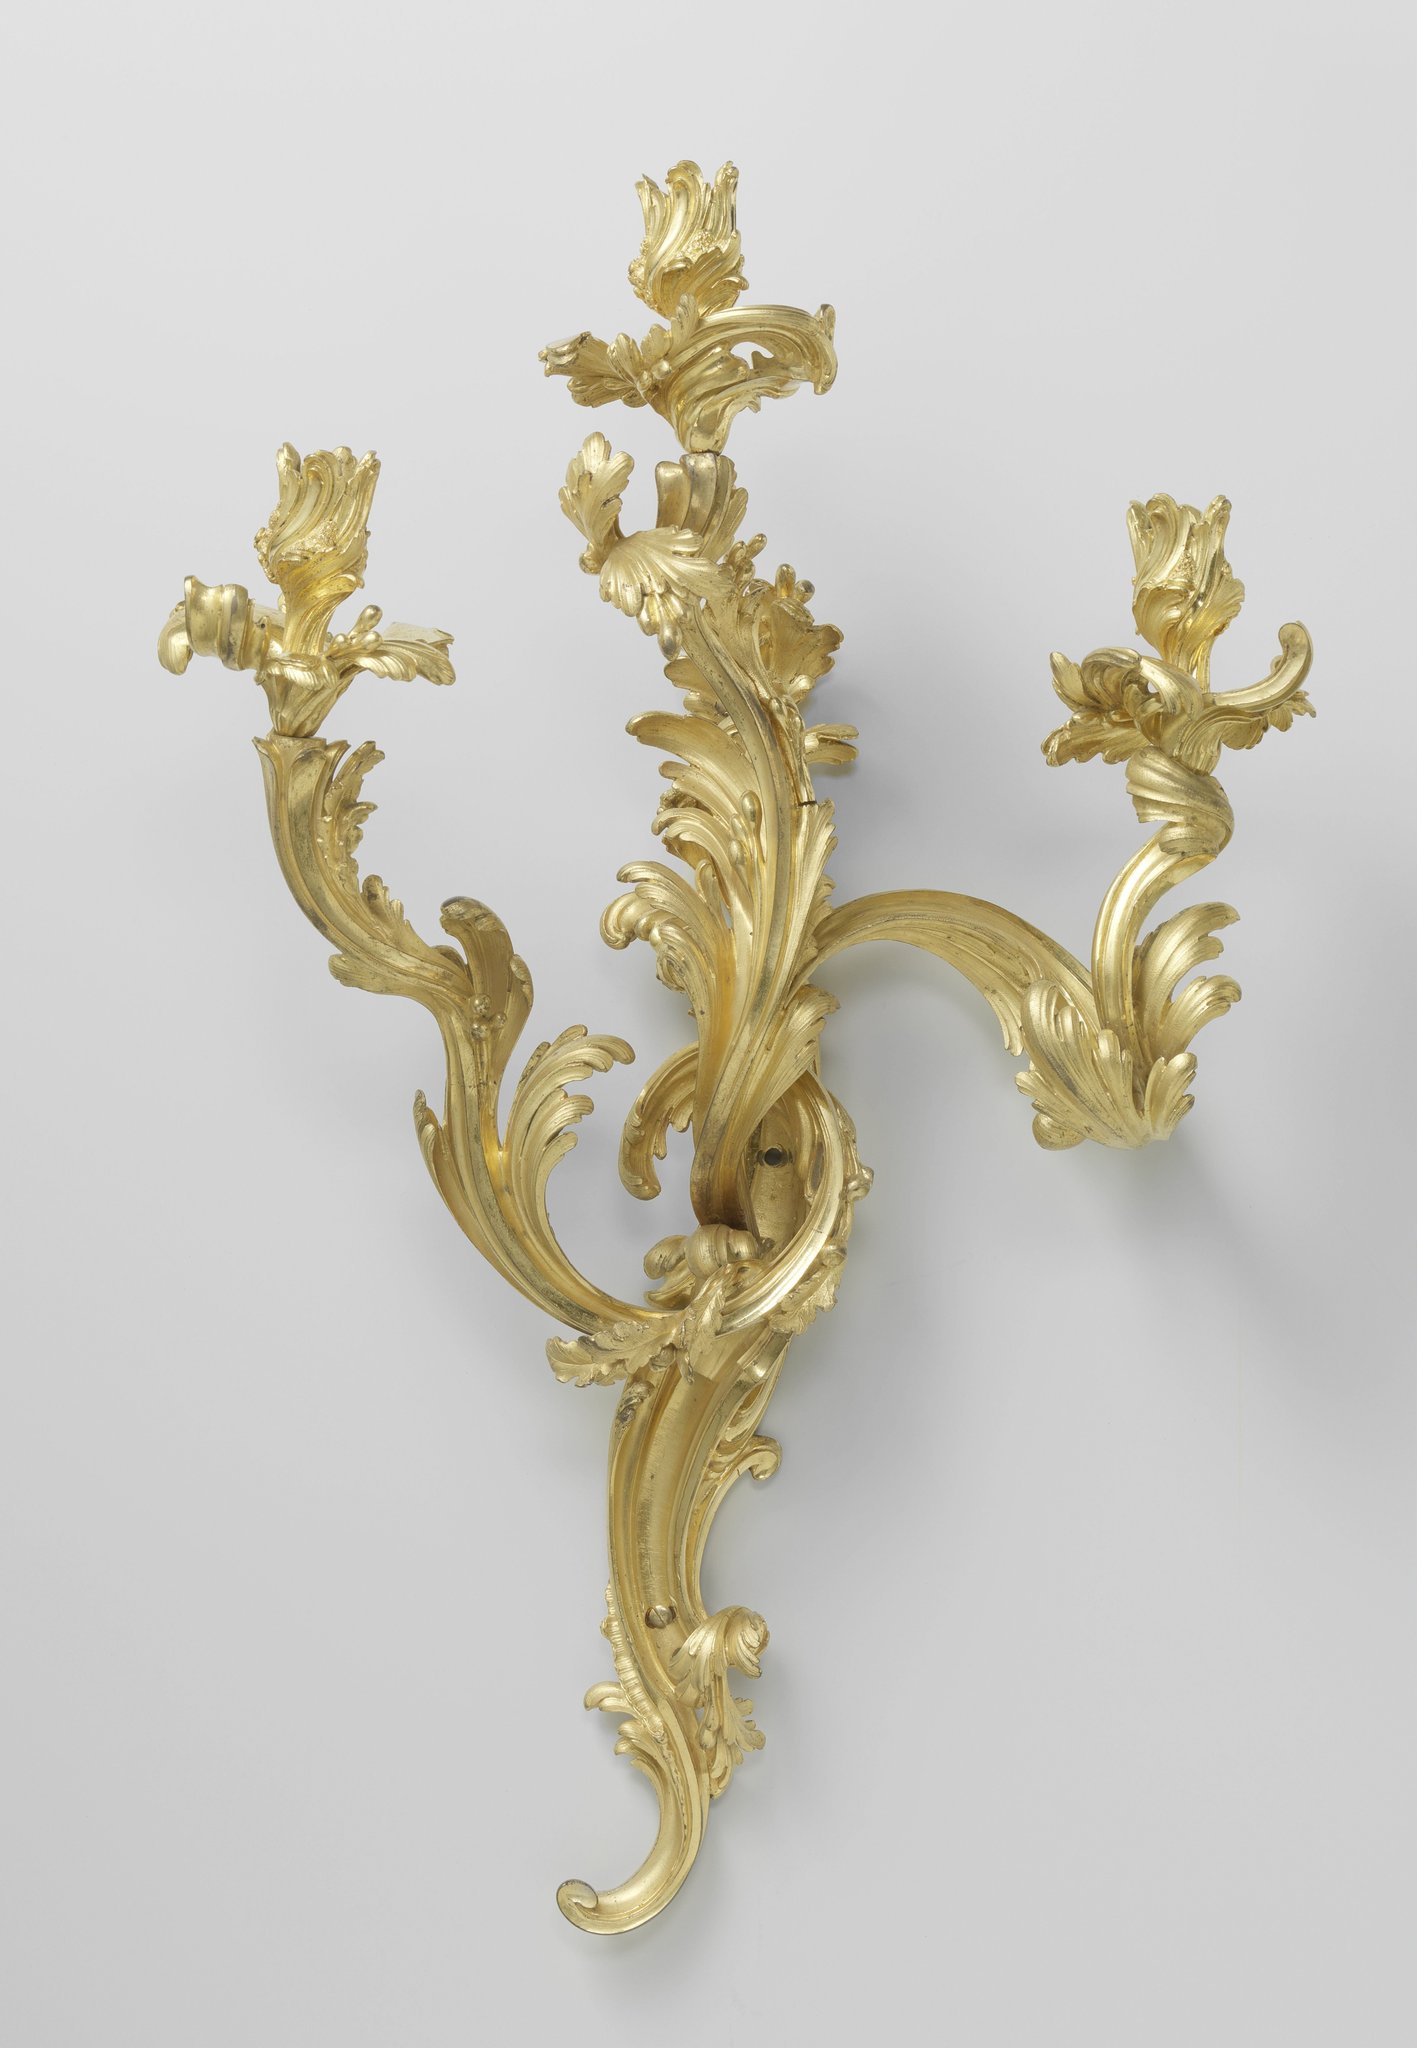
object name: lighting device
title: Wandarm van verguld brons met drie, uit asymmetrische C- en S-voluten opgebouwde armen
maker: Anonymous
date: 1750-1760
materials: bronze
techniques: gilding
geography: paris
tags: ornament derived from plant forms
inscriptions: mark: ‘No 14’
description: Cartel clock. Gilt bronze. Paris, c. 1745, by Charles Cressent, the movement by Jean Baptiste Hervé. Two wall-lights. Gilt bronze. Paris, c. 1750.